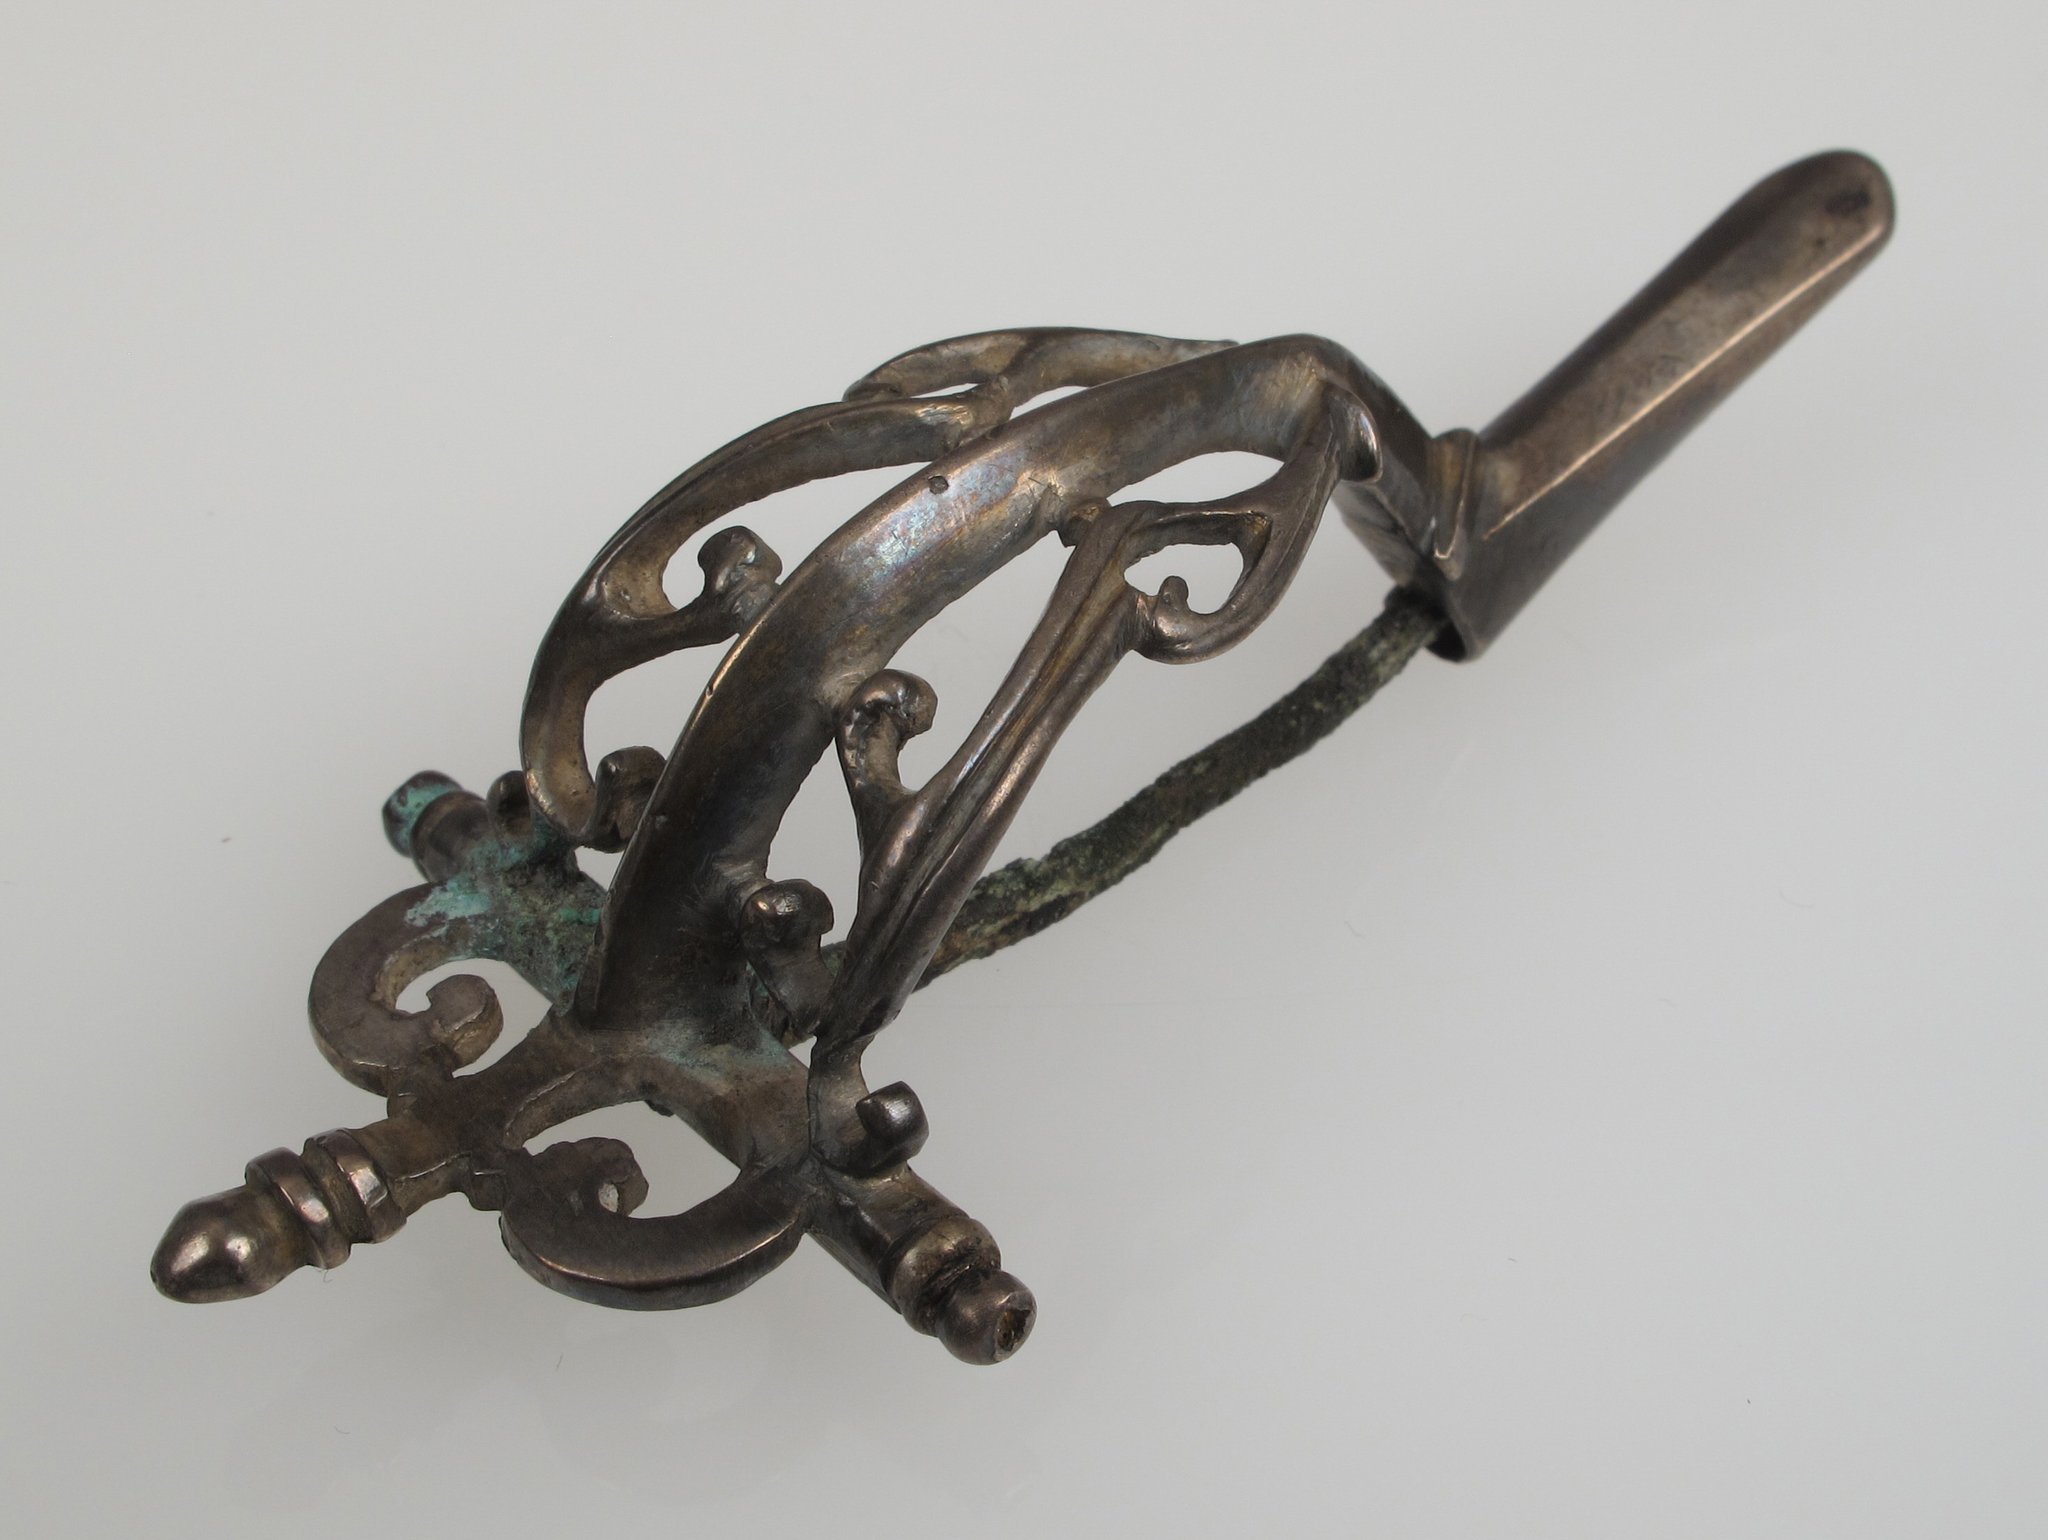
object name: brooch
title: Crossbow Brooch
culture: roman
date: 101-300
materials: silver